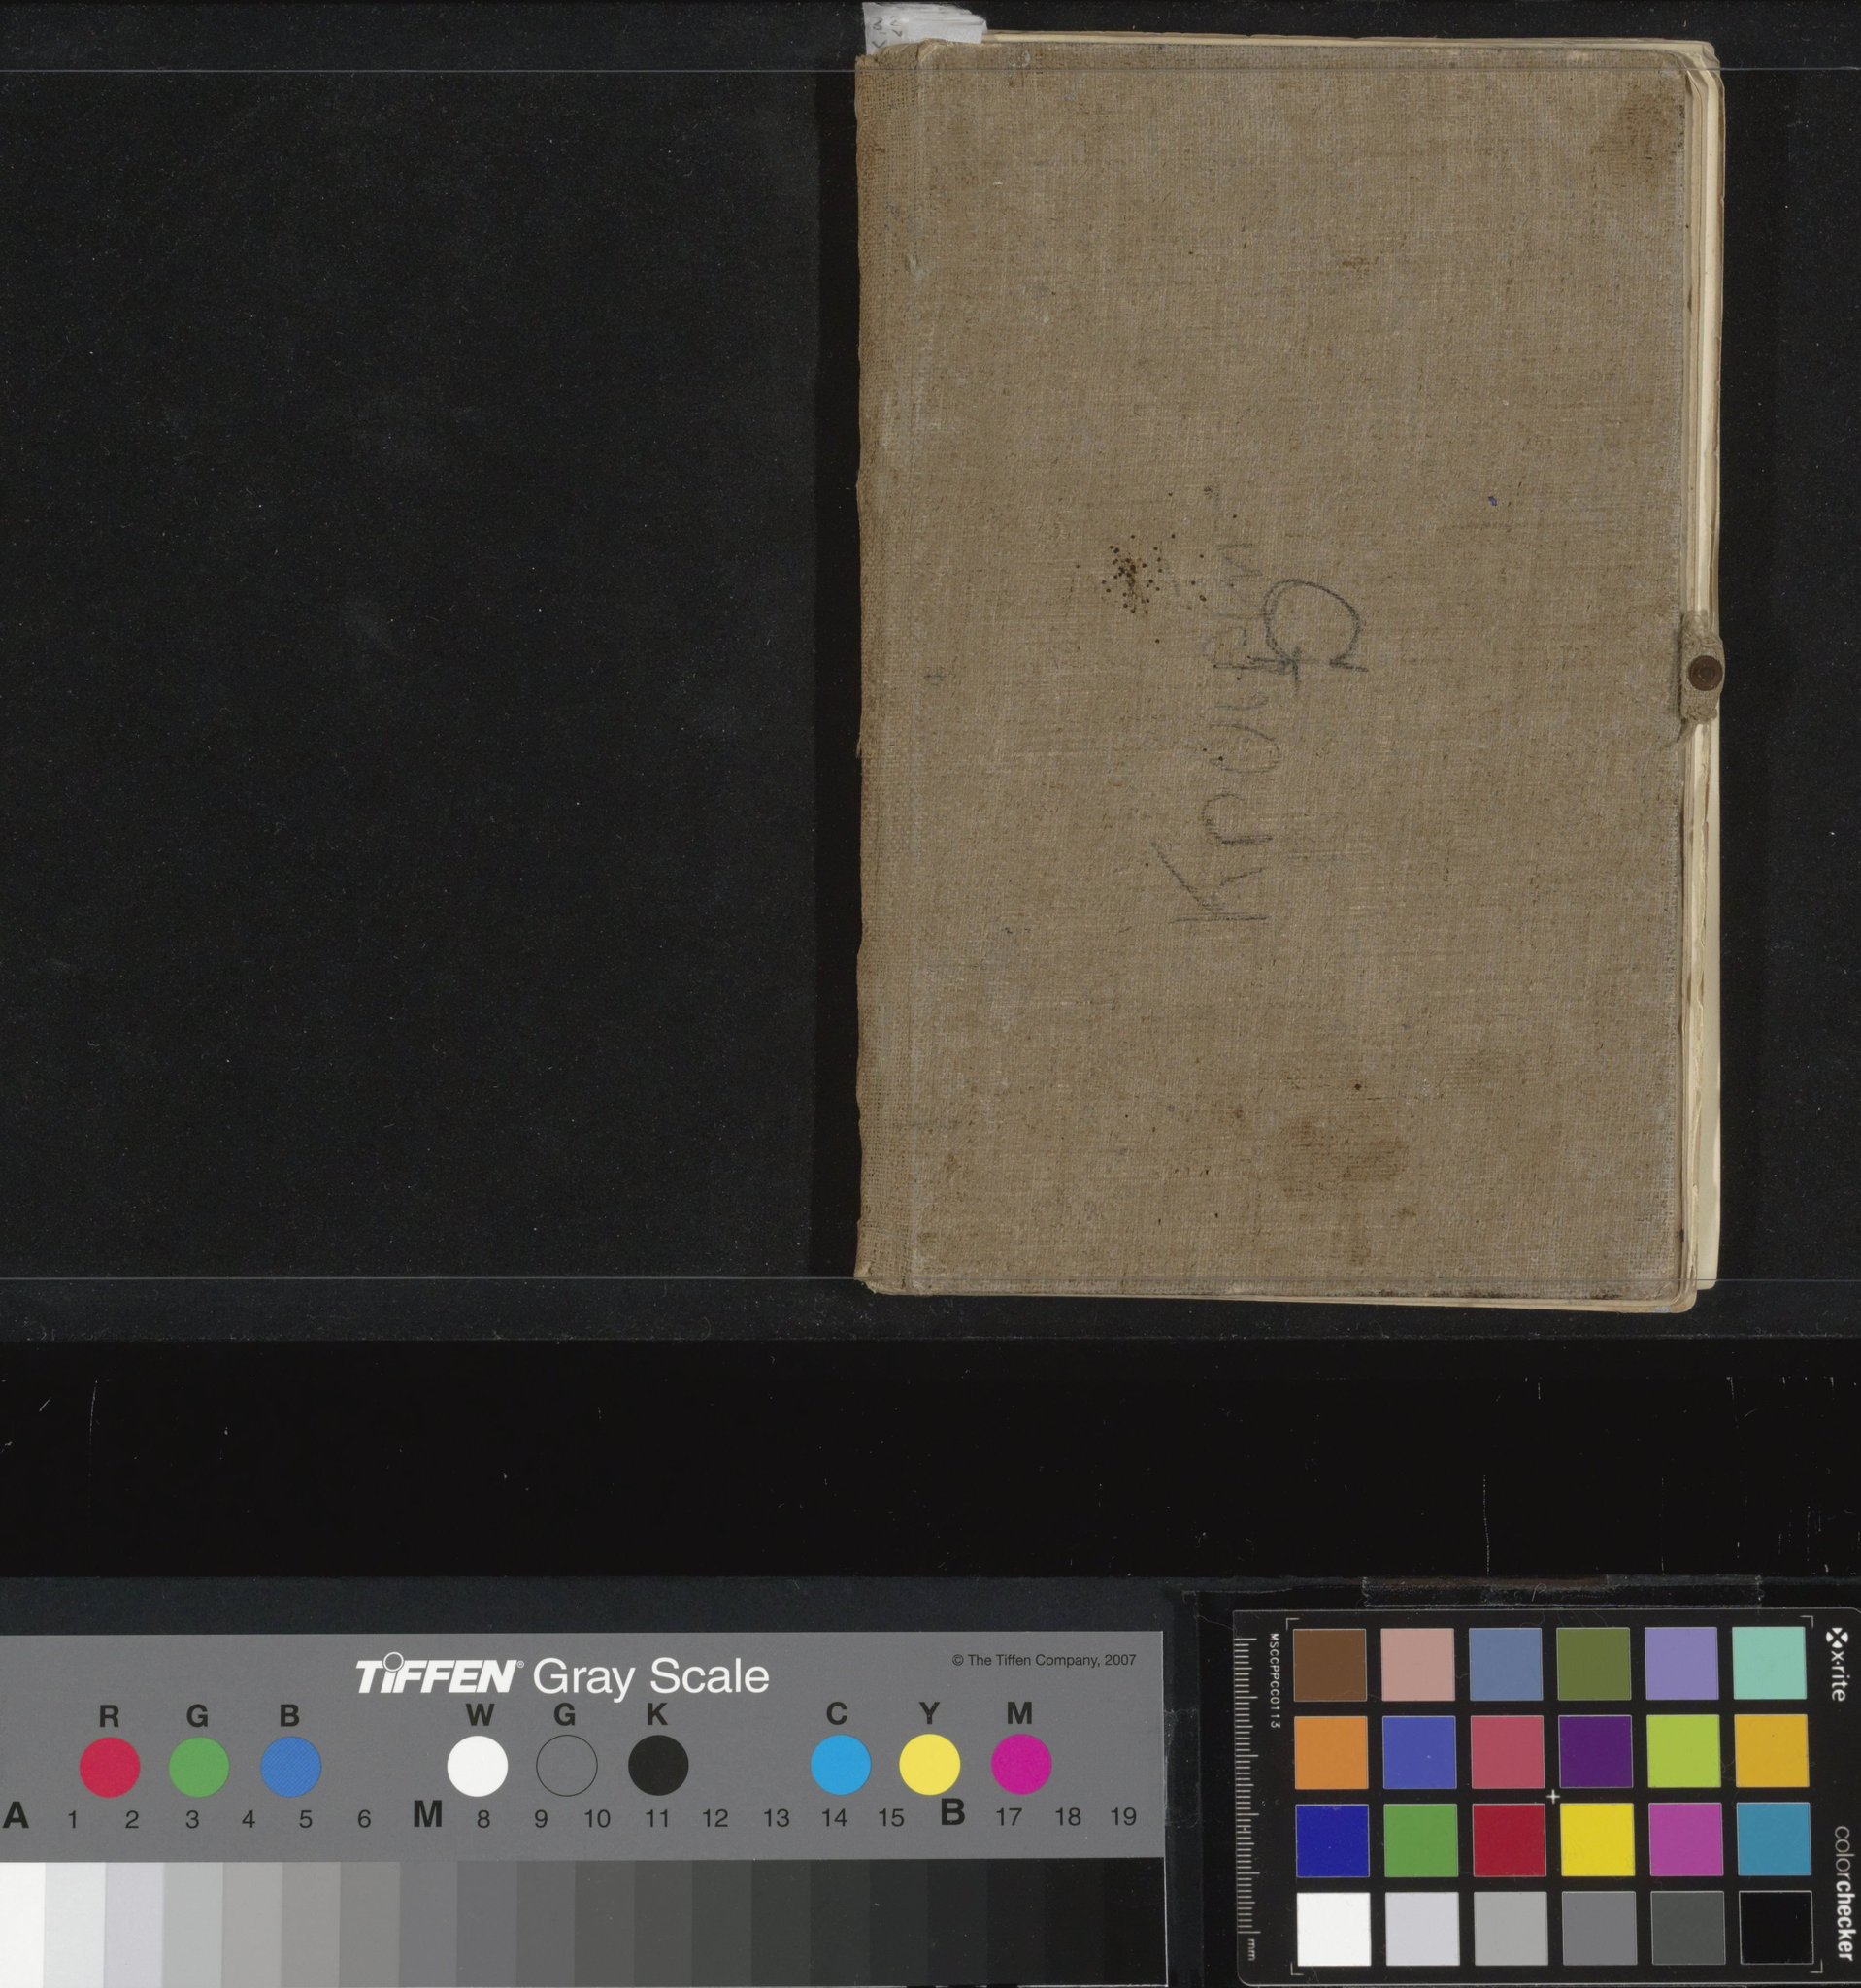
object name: sketchbook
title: Schetsboek met 45 bladen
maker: cornelis vreedenburgh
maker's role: draughtsman, print maker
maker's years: 1880-1946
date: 1890-1946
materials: cardboard, chalk, ink, linen, paper, pencil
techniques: pen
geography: amsterdam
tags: city-view, and landscape with man-made constructions, landscapes, canals, waters (in city), amsterdam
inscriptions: annotation: ‘Kpoip[...]/ G’, factory mark: ‘SKETCHER'S/ NOTE BOOK/ SERIES A 42/ containing 80 leaves of good white paper./ MANUFACTURED BY/ GEO. ROWNEY & CO., LONDON, W., ENGLAND/ SIZE No. 2- 8 1/2 x 5 1/2 inches./ Dimensions de l'album 21 x 14 cm.’, annotation: ‘G’, collector's mark: Lugt 2228a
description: De volgende bladen uit het schetsboek zijn blanco: 1(V), 3(V), 4(V), 6(V) t/m 16(V), 17(R), 18(V), 24(V), 26(V) t/m 32(V), 34(V) t/m 38(V), 39, 40(V), 41, 42, 43(R) en 44(R).